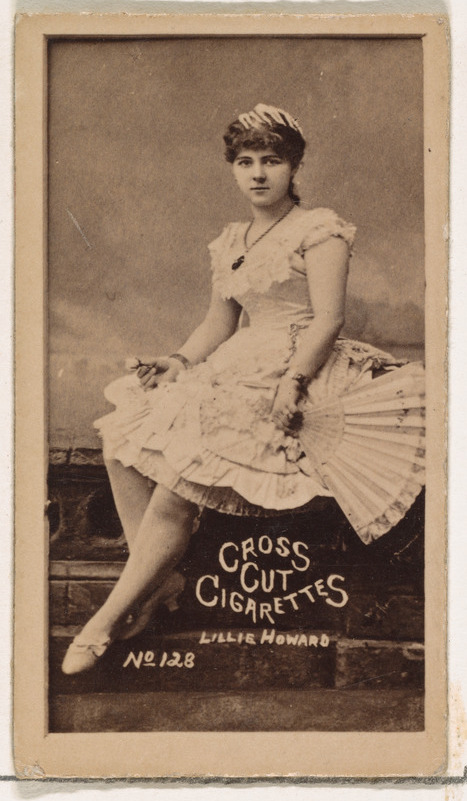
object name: print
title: Card Number 128, Lillie Howard, from the Actors and Actresses series (N145-1) issued by Duke Sons & Co. to promote Cross Cut Cigarettes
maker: w. duke, sons & co.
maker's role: publisher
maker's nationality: american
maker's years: 1870-1920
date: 1880-1889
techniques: albumen silver print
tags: fans,portraits,women,actresses